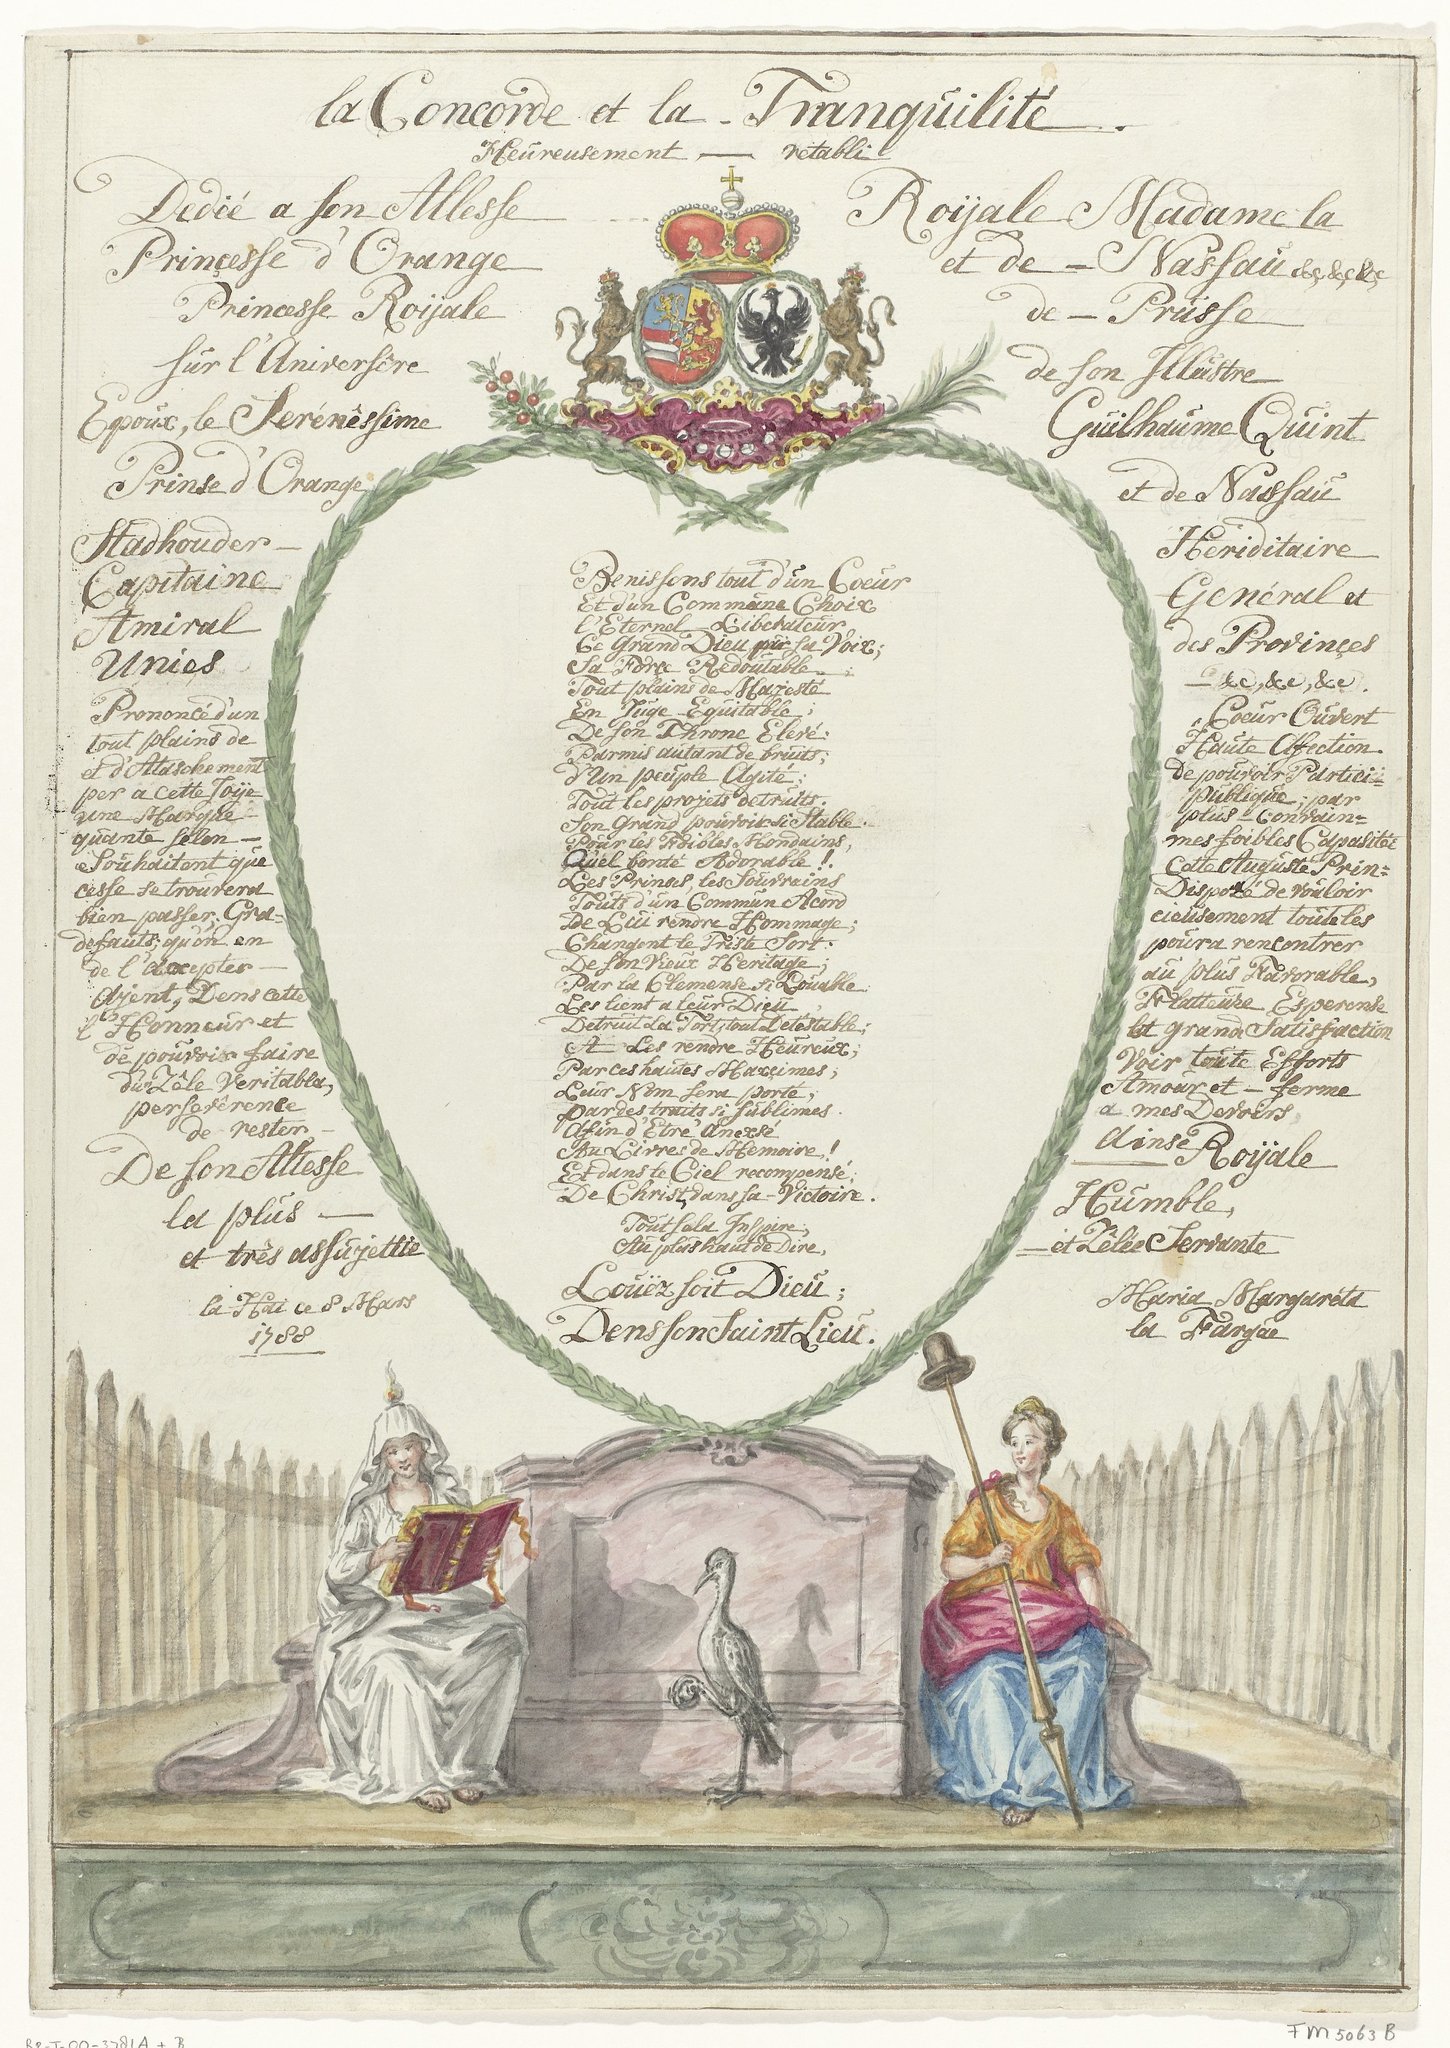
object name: drawing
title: la Concorde et la Tranquilité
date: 1788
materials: paper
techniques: writing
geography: the hague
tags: william v (prince of orange), berlin, painter, wilhelmina of prussia (princess of orange), allegorical representations ~ religion; 'religione', 'religione de ss. mauritio e lazaro', 'religione vera christiana' (ripa), freedom, liberty; 'libertà' (ripa) (+ abstract concept represented by female figure)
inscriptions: collector's mark: Lugt 2228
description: Allegorisch blad met vers opgedragen aan prinses Wilhelmina van Pruisen ter ere van de veertigste verjaardag van haar echtgenoot prins Willem V op 8 maart 1788, in de vorm van een wensbrief. Centraal op het blad is een hartvormige cartouche van gevlochten takken te zien. In en rondom de cartouche staat een vers in het Frans die de aanleiding voor het blad vermeldt: de veertigste verjaardag van stadhouder Willem V op 8 maart 1788. Boven op de cartouche zijn de familiewapens van prinses Wilhelmina van Pruisen, echtgenote van Willem V, bestaande uit links het wapen van de stadhouderlijke familie Oranje-Nassau en rechts het wapen van de Pruisische keizerlijke familie. De wapens worden aan weerszijden vastgehouden door een staande leeuw, verbonden met een kroon erbovenop. Links groeit een tak met oranjeappels en rechts een psalmtak. Onderaan de cartouche zitten aan weerszijden van een stenen monument Geloof en Vrijheid. Geloof is herkenbaar aan de vlam op haar hoofd, als symbool van het licht van het geloof, en heeft een Bijbel in haar handen. Vrijheid draagt een lans in haar rechterhand, bekroond met een vrijheidshoed, een symbool dat sinds de Opstand (1568-1648) veelvuldig werd gebruikt in de Republiek en refereert aan de Romeinse ceremonie waarin een vrijgelaten tot slaaf gemaakte in de tempel van Feronia de vrijheidshoed ontving als verzegeling van zijn of haar nieuwe status. Tussen de allegorieën staat een kraanvogel, die met de steen in zijn opgetrokken poot symbool staat voor waakzaamheid. Voor meer uitleg, zie Toelichting. Bij deze tekening hoort een tweede blad (RP-T-00-3781B).